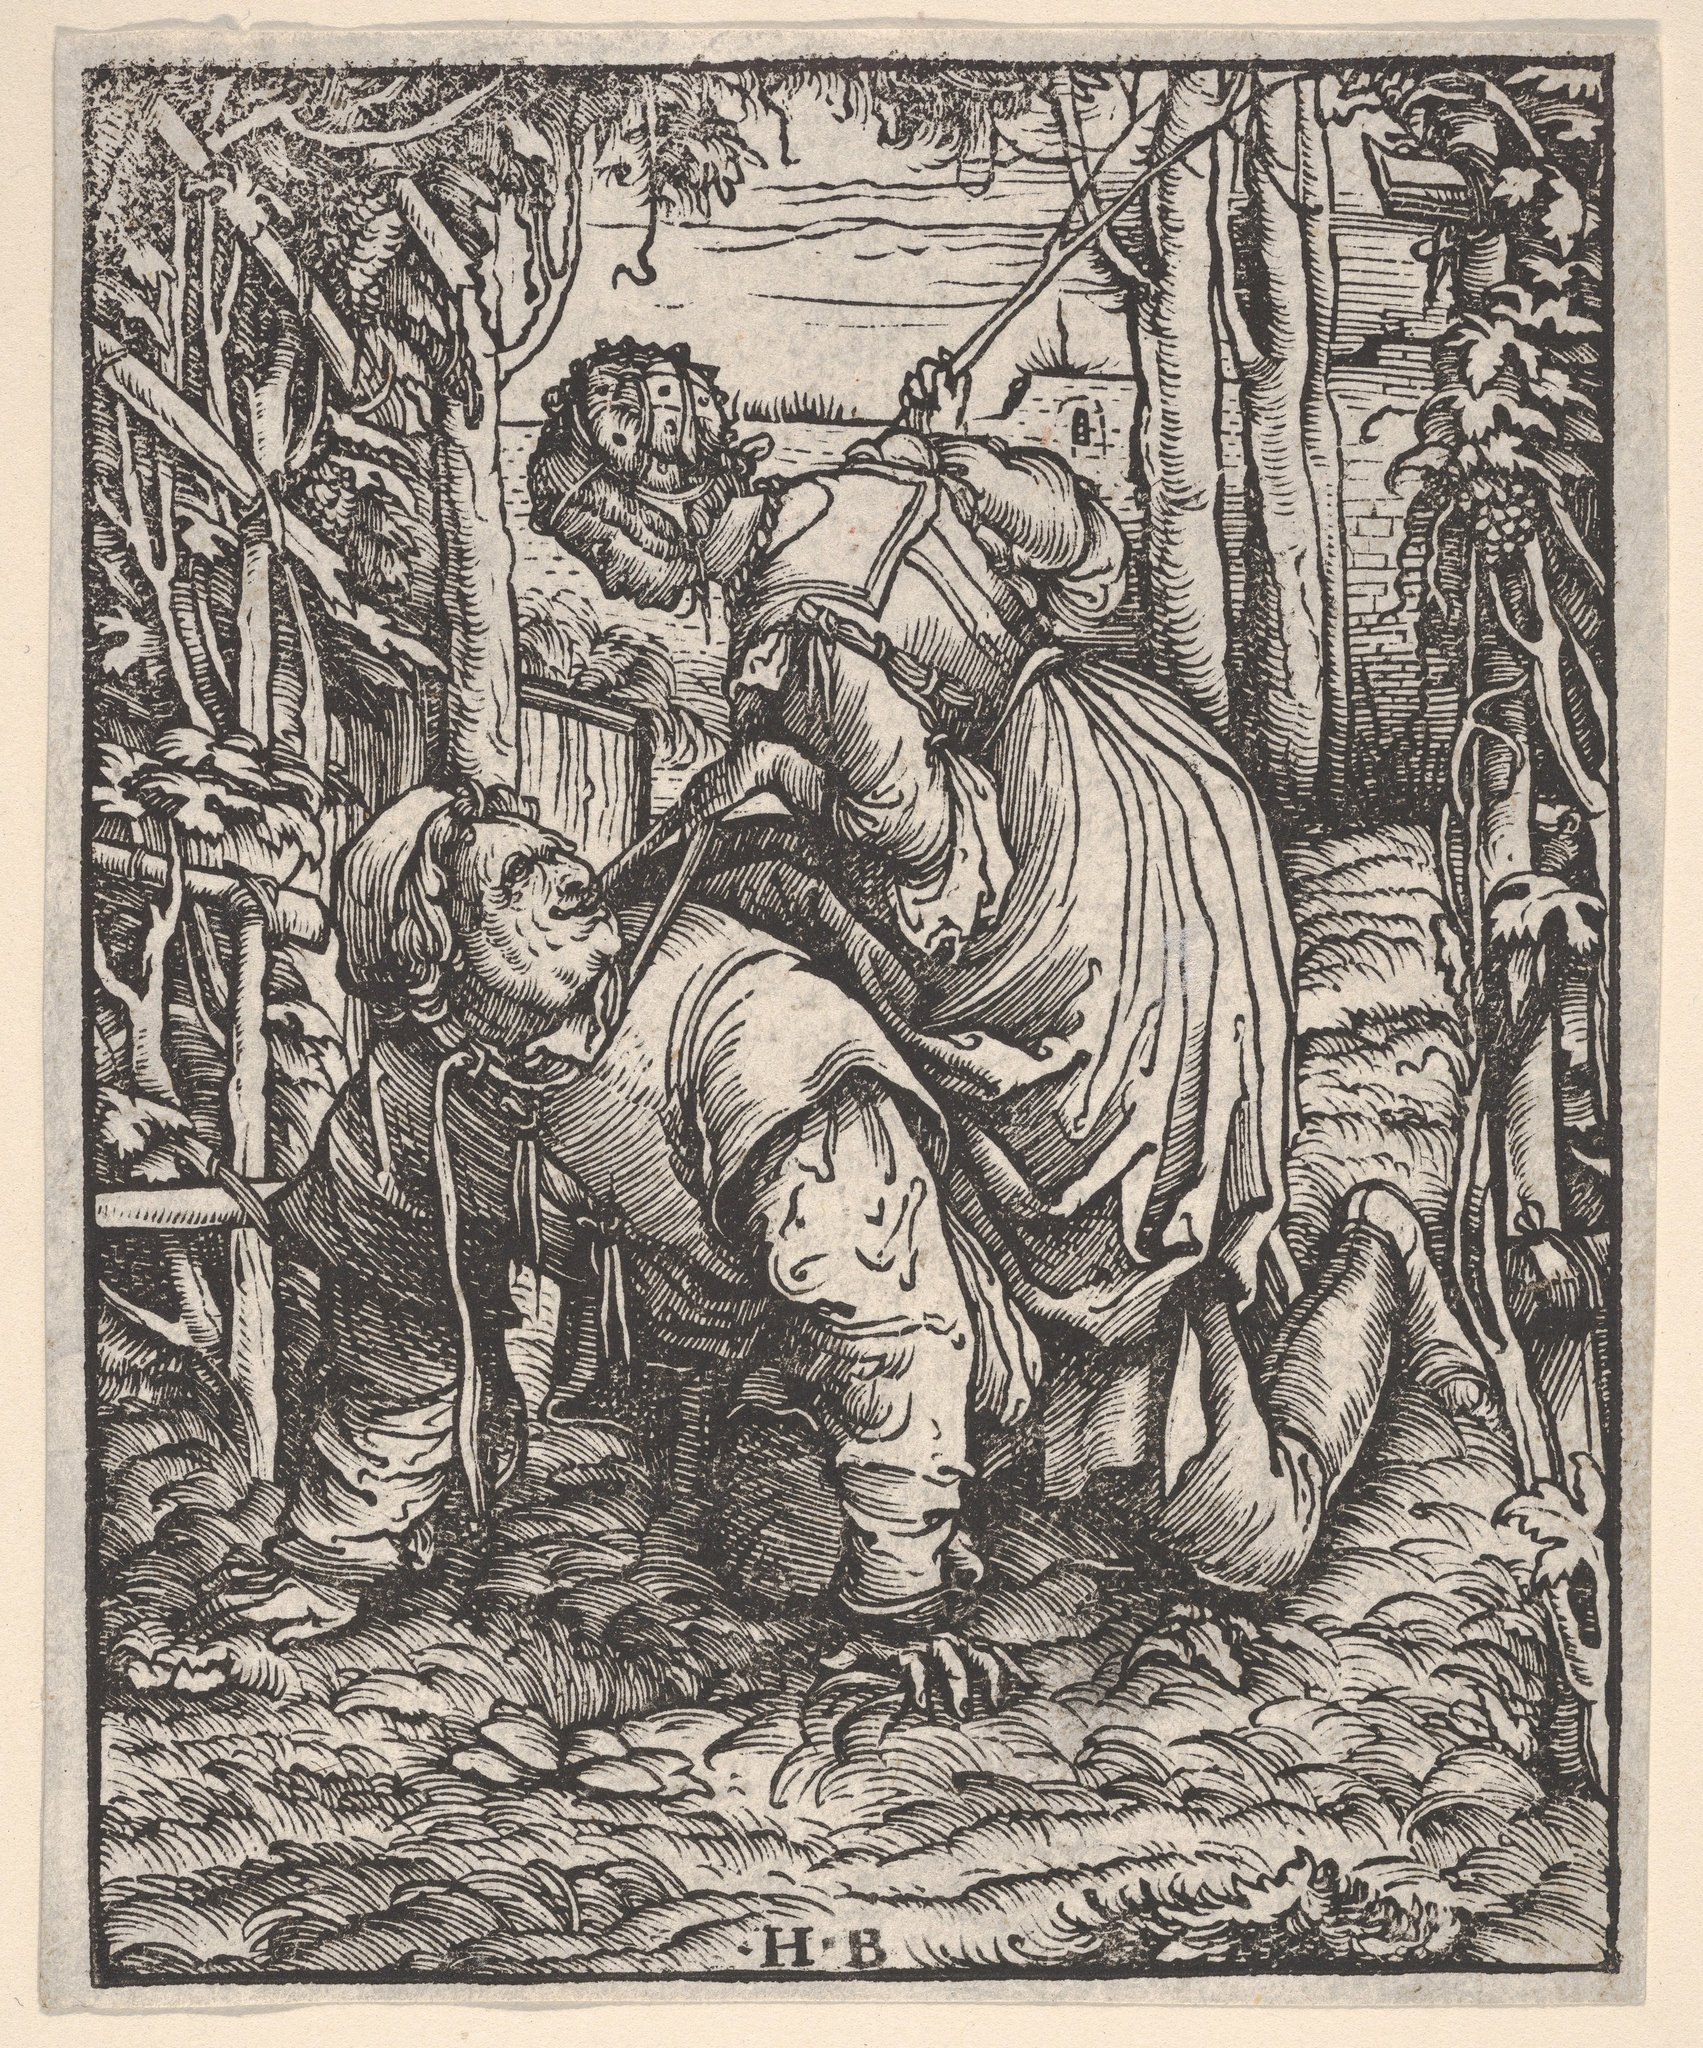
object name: print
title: Aristotle and Phyllis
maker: hans burgkmair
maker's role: artist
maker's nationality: german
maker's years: 1473-1531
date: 1498-1531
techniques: woodcut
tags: men,women